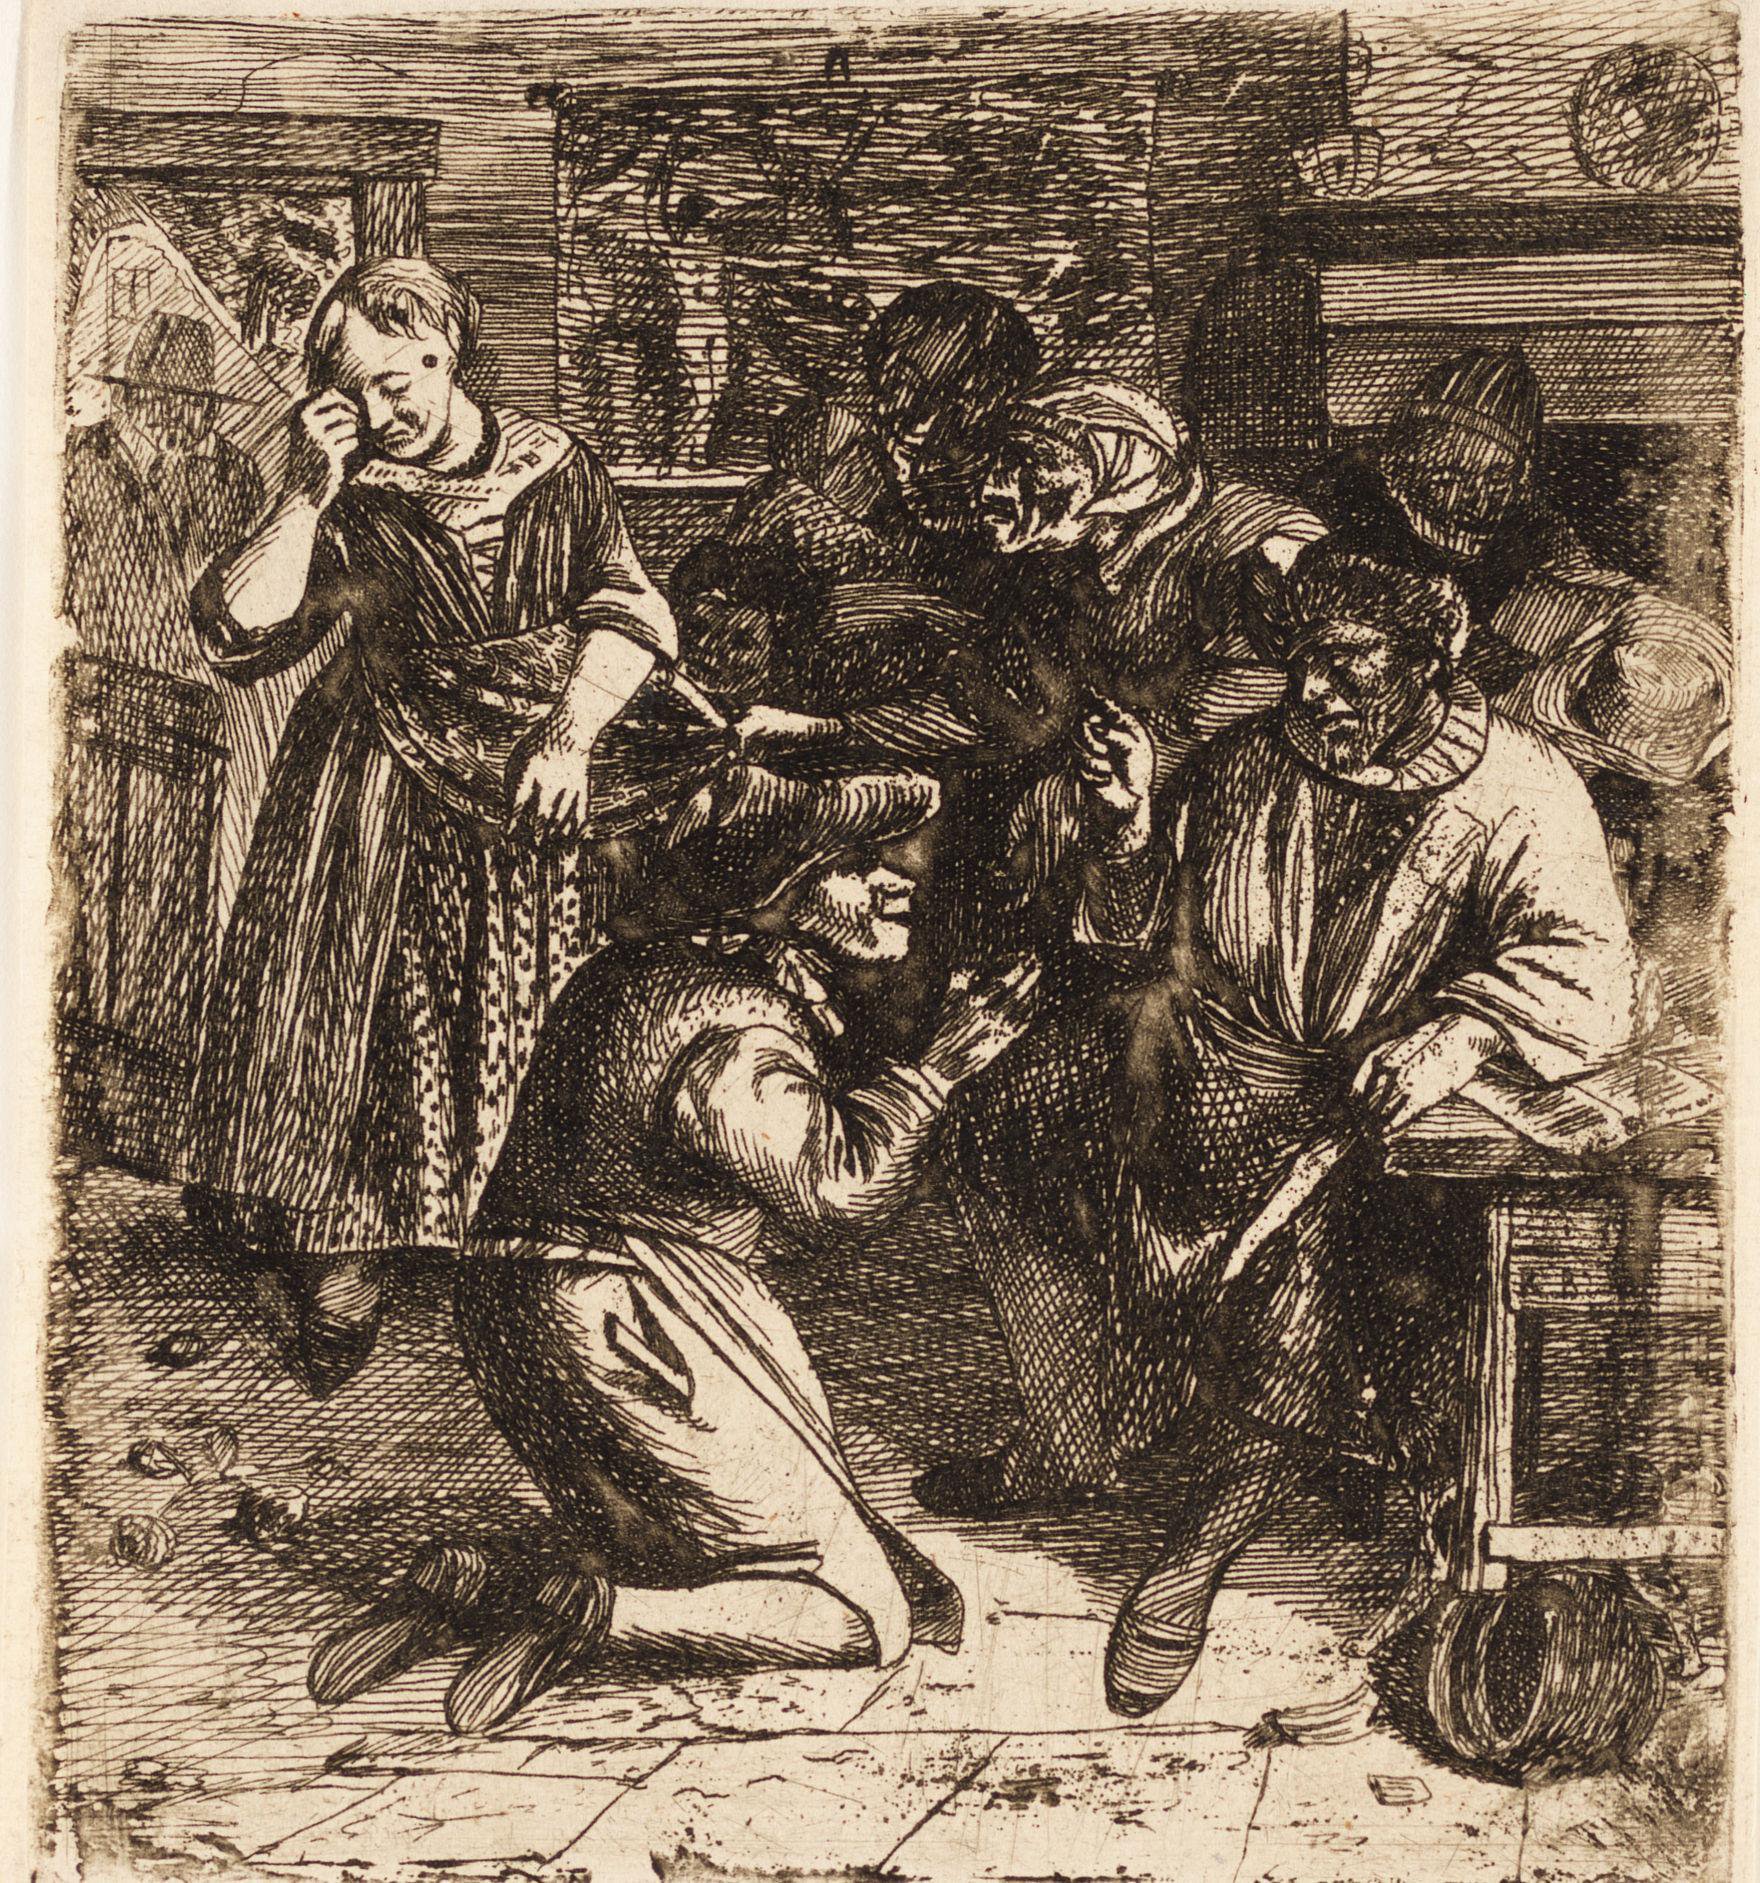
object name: print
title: Jong stel bij het opbiechten van een misstap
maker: richard brakenburg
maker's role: print maker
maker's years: 1650-1702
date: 1670-1702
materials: paper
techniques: etching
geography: netherlands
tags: pregnant woman, fallen woman, pregnancy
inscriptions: collector's mark: Lugt 2228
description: Boereninterieur met een jonge man die op de grond knielt en om vergiffenis vraagt aan de vader van het meisje, dat hij verleid heeft. Het meisje staat achter de knielende man en een oudere vrouw trekt haar schort opzij zodat haar buikje zichtbaar wordt. Aan de muur hangt een prent met Adam en Eva.